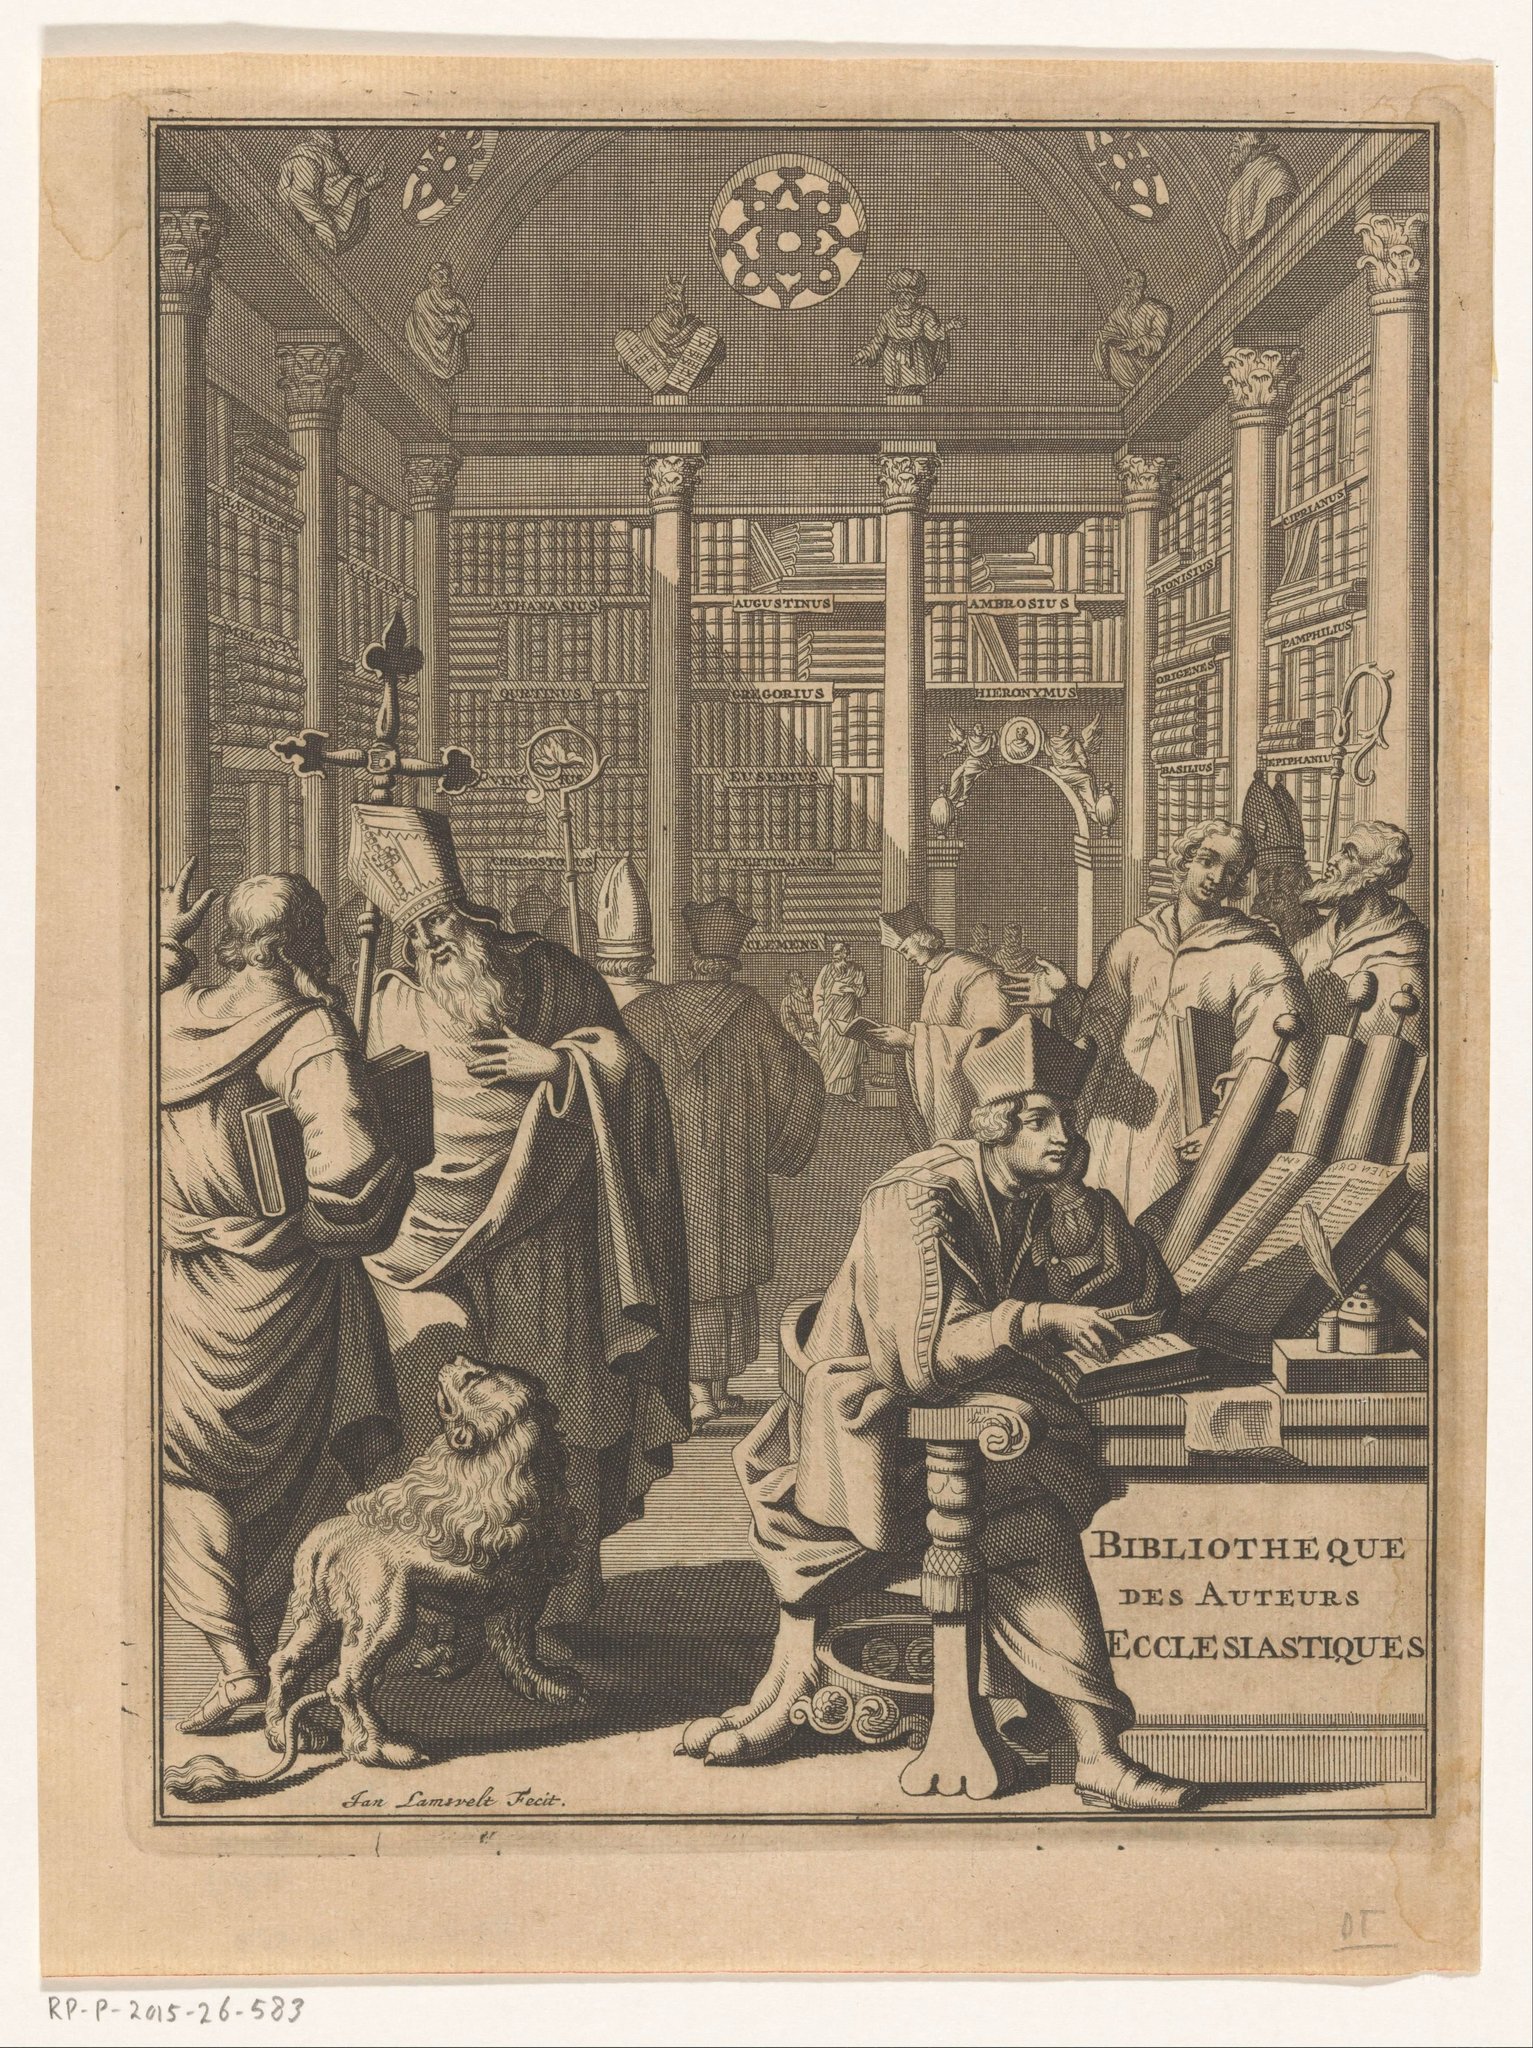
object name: titelblad, titelpagina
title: Titelpagina voor: L.E. Dupin, Nouvelle bibliotheque des auteurs ecclesiastiques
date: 1710-1715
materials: paper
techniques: engraving, etching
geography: amsterdam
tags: writing-table, writing-desk, bookshelves, archbishop, bishop, etc. (roman catholic), ink-well, cardinal, mark (marcus) the evangelist, and bishop of alexandria; possible attributes: book, (winged) lion, pen and inkhorn, scroll, study; 'studiolo'; library, book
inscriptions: collector's mark: Lugt 2228, collector's mark: Lugt 4779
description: Interieur van een bibliotheek met bisschoppen, kardinalen en andere christelijke auteurs, rechts voor een kardinaal achter een schrijftafel en links de evangelist Marcus. Tegen de wanden staan boekenkasten met bordjes van christelijke auteurs.